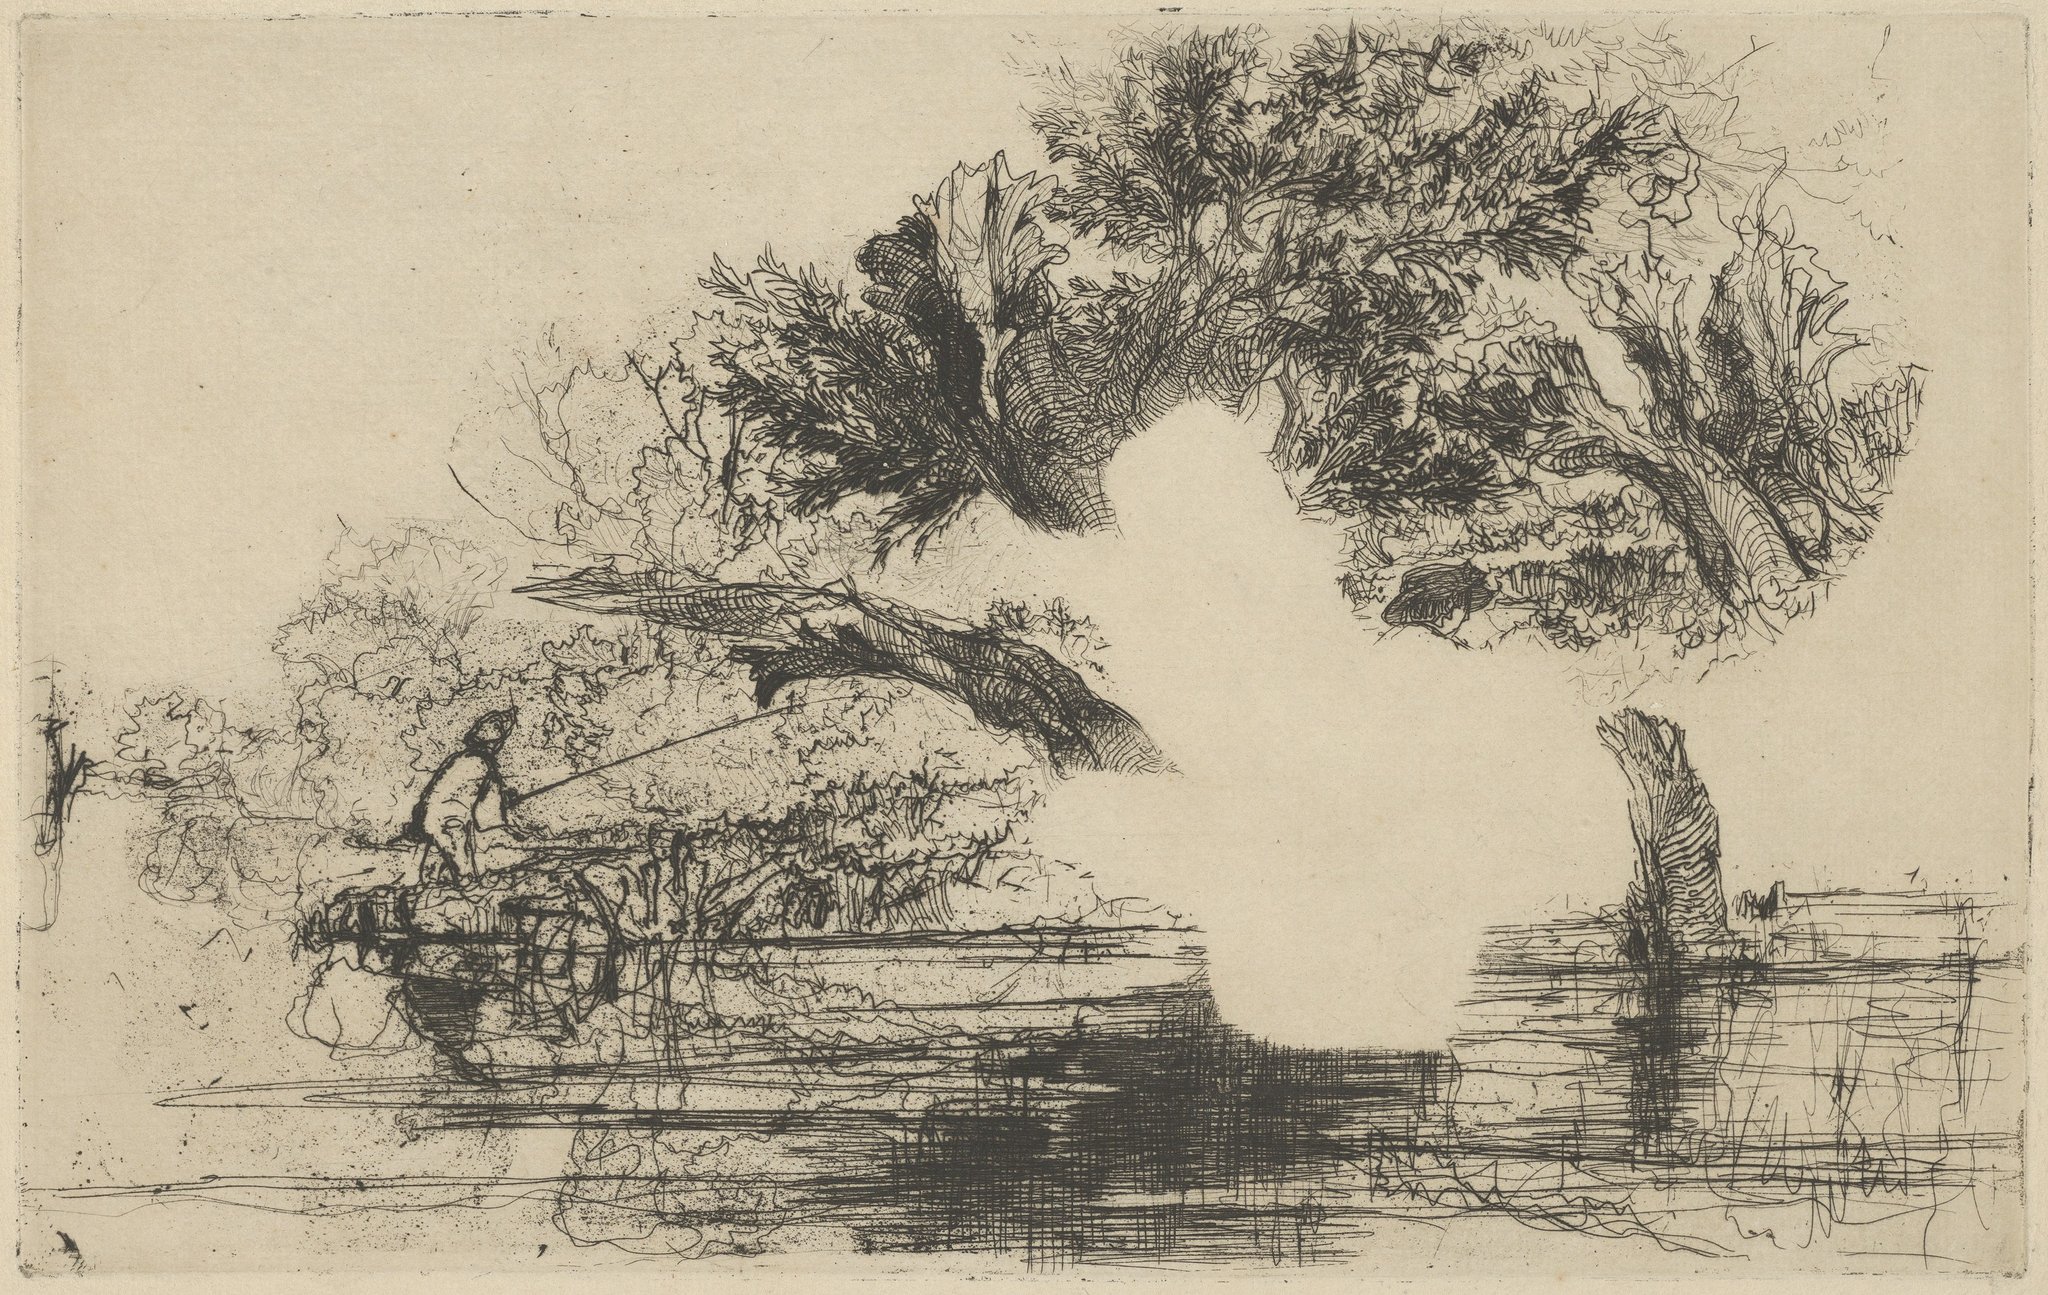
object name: print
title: Penton Hook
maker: francis seymour haden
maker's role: artist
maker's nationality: british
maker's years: 1818-1910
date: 1864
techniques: drypoint, etching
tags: boys,fishing,rivers